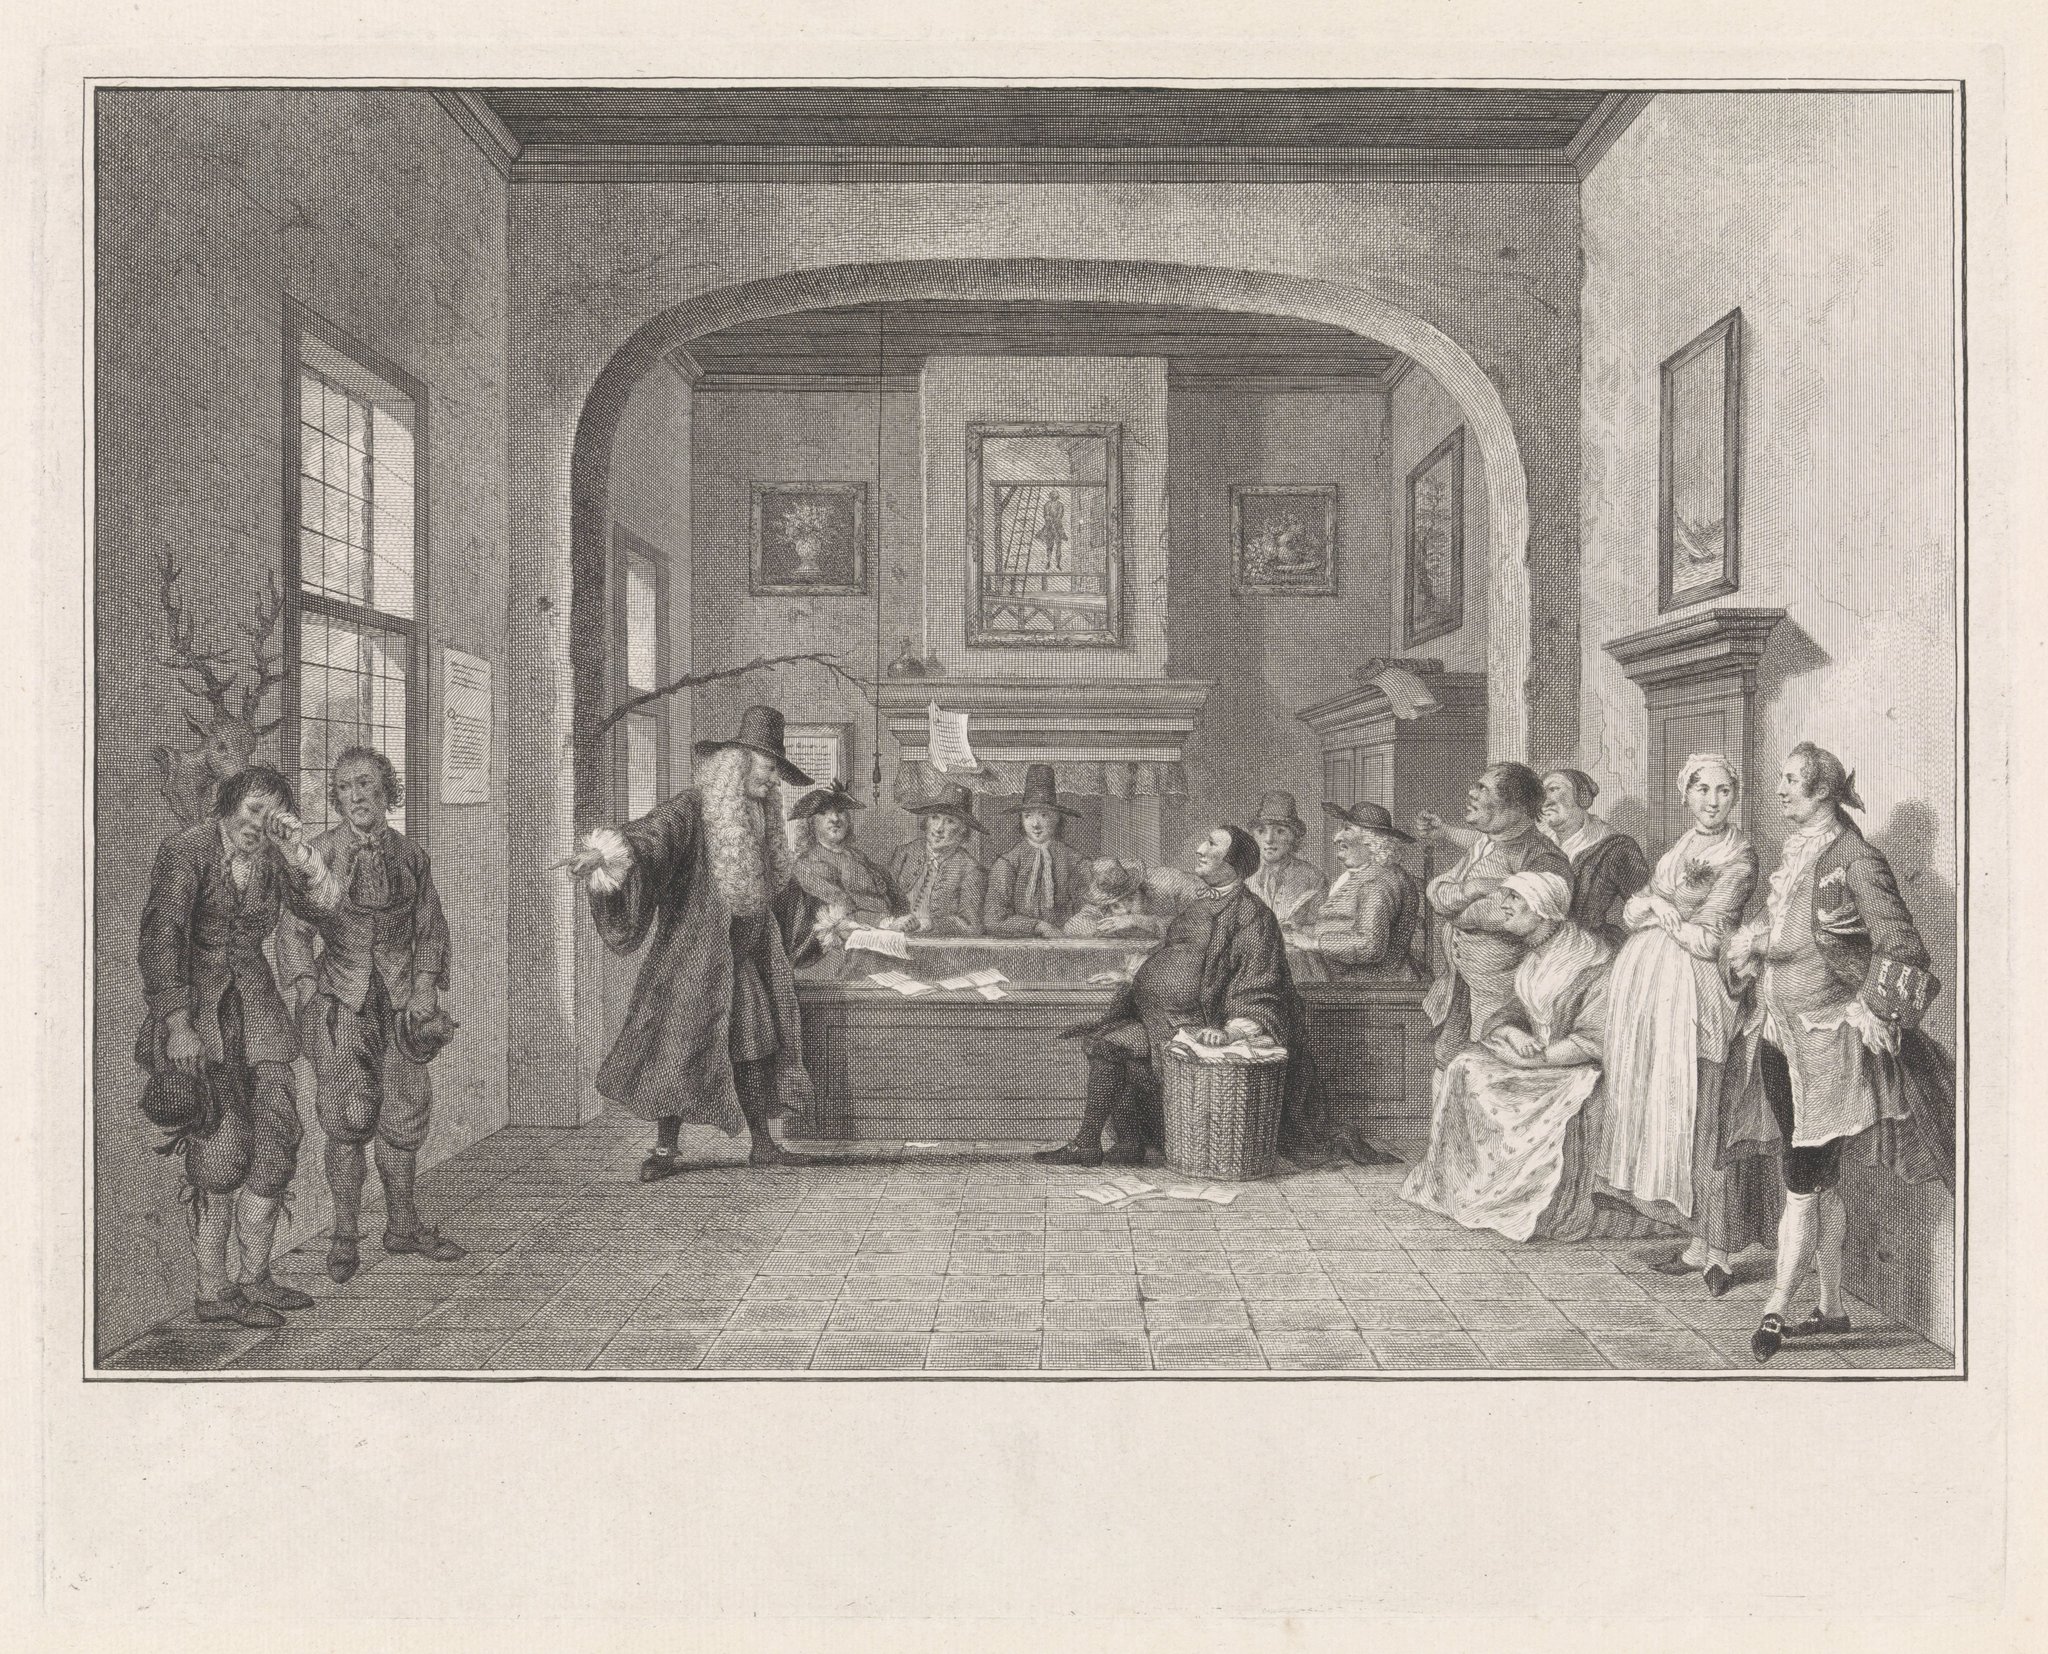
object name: print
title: De boerenrechtbank te Puiterveen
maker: pieter tanjé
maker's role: draughtsman, print maker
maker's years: 1706-1761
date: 1752-1761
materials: paper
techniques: engraving, etching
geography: amsterdam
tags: lawyer, attorney at law, pregnant woman, comedy, court-room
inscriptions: collector's mark: Lugt 240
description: Voor de boerenrechtbank van Puiterveen staan links de huilende Fobert en zijn vader en rechts de zwangere Swaantje tussen jonker Jan en haar ouders. Swaantje is bezwangerd door de zoon van de heer van Puijterveen, maar Fobert wordt van deze daad beschuldigd. De corrupte advocaat van Fobert is aan het pleiten, terwijl de advocaat van de tegenpartij toehoort. Achter de tafel zitten schout en schepenen. Scène uit het derde bedrijf van het toneelstuk Beslikte Swaantje, en Drooge Fobert; of de boere rechtbank, van Abraham Alewijn.